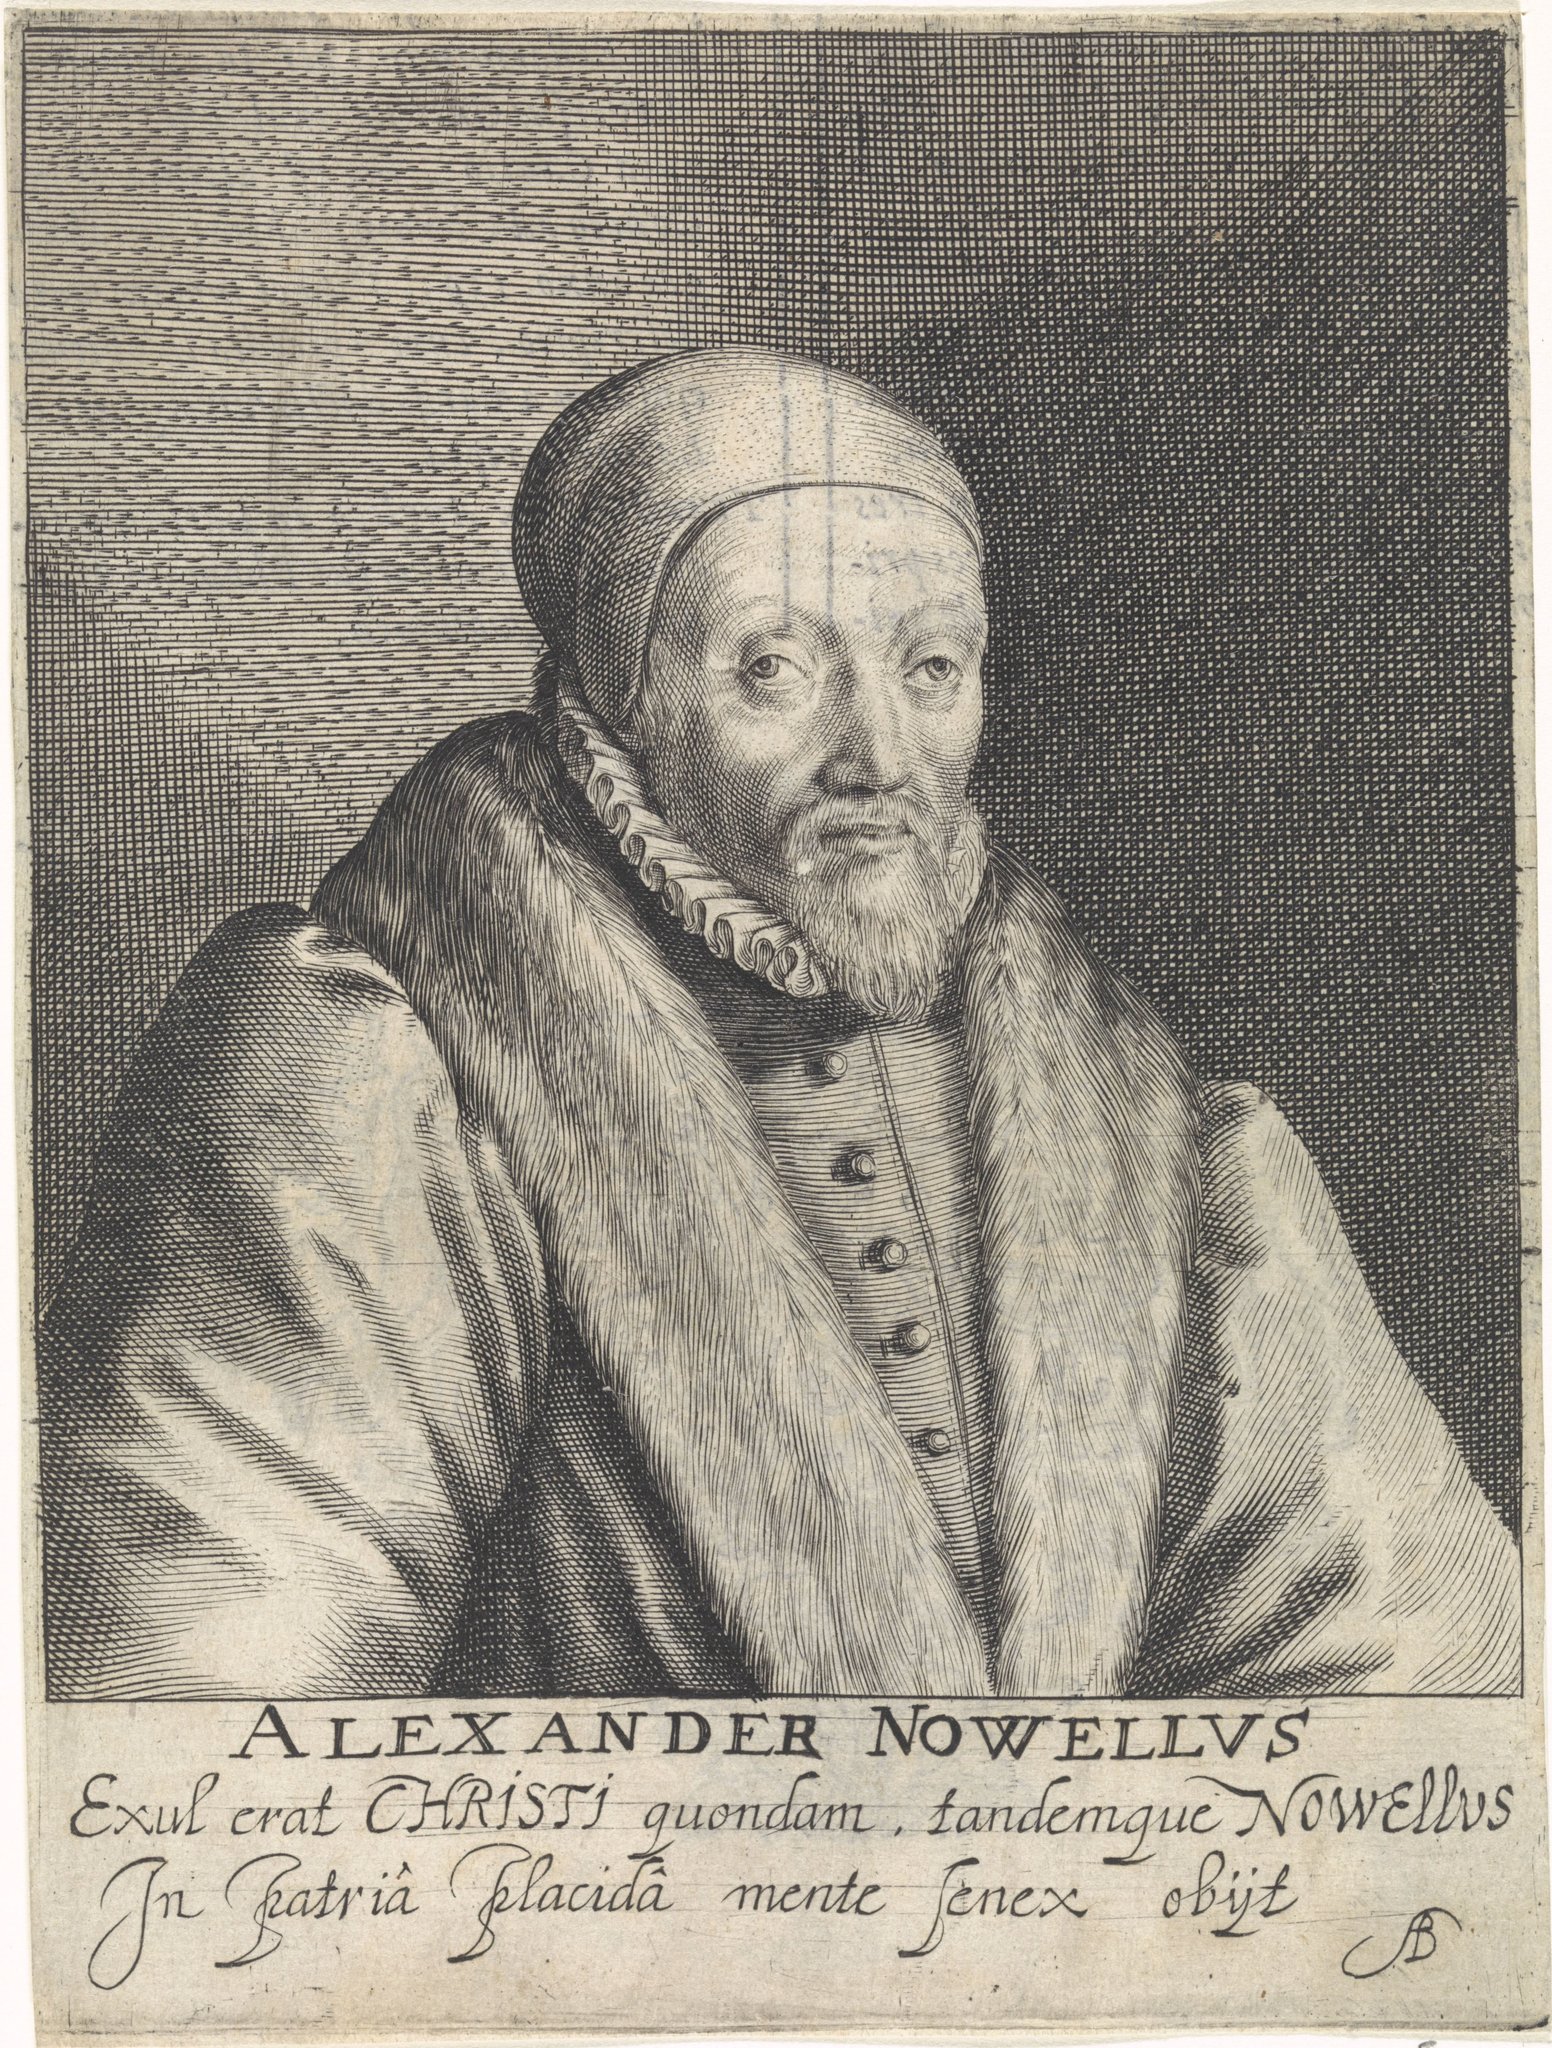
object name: print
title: Portret van Alexander Nowell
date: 1620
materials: paper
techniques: engraving, letterpress printing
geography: utrecht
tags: alexander nowell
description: Portret van de theoloog Alexander Nowell. Hij was deken bij de St. Paul kathedraal in Londen. In de marge de naam van de geportretteerde en een tweeregelig onderschrift in het Latijn.